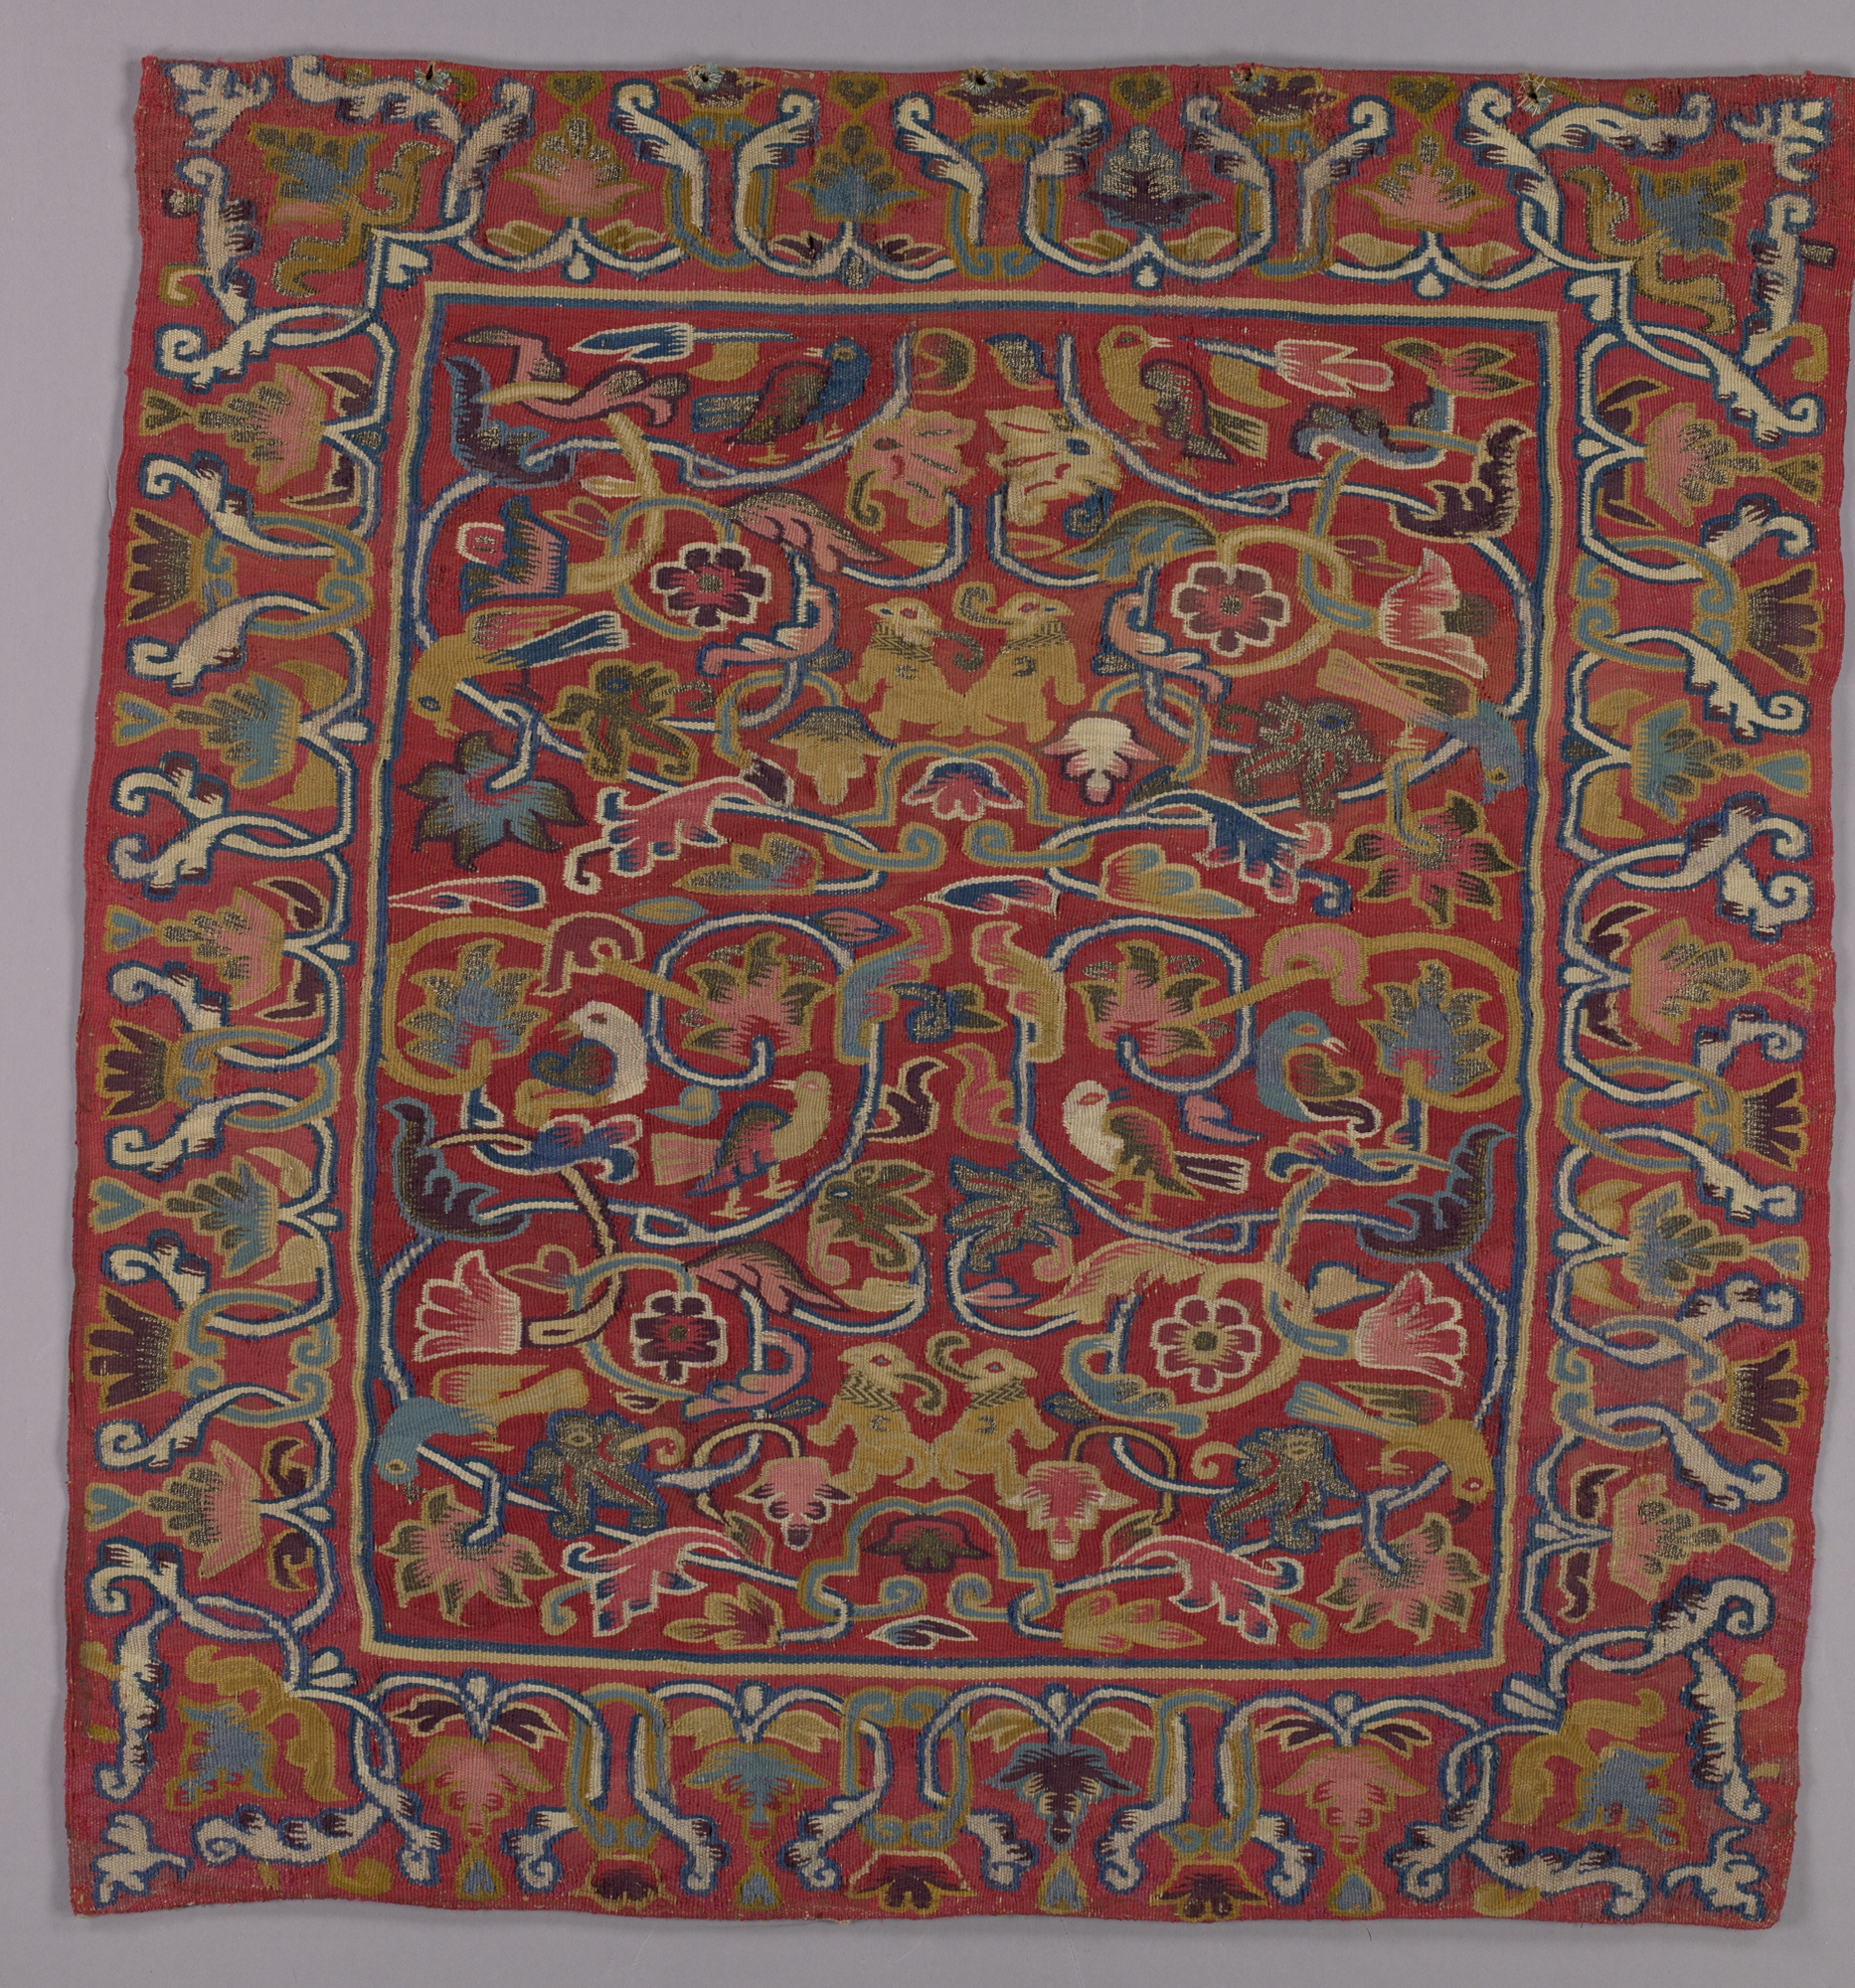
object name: upholstery panel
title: Seat cover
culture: peruvian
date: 1667-1733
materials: animal fiber, cotton, silk, silver gilt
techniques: weave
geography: peru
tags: animals,birds,flowers